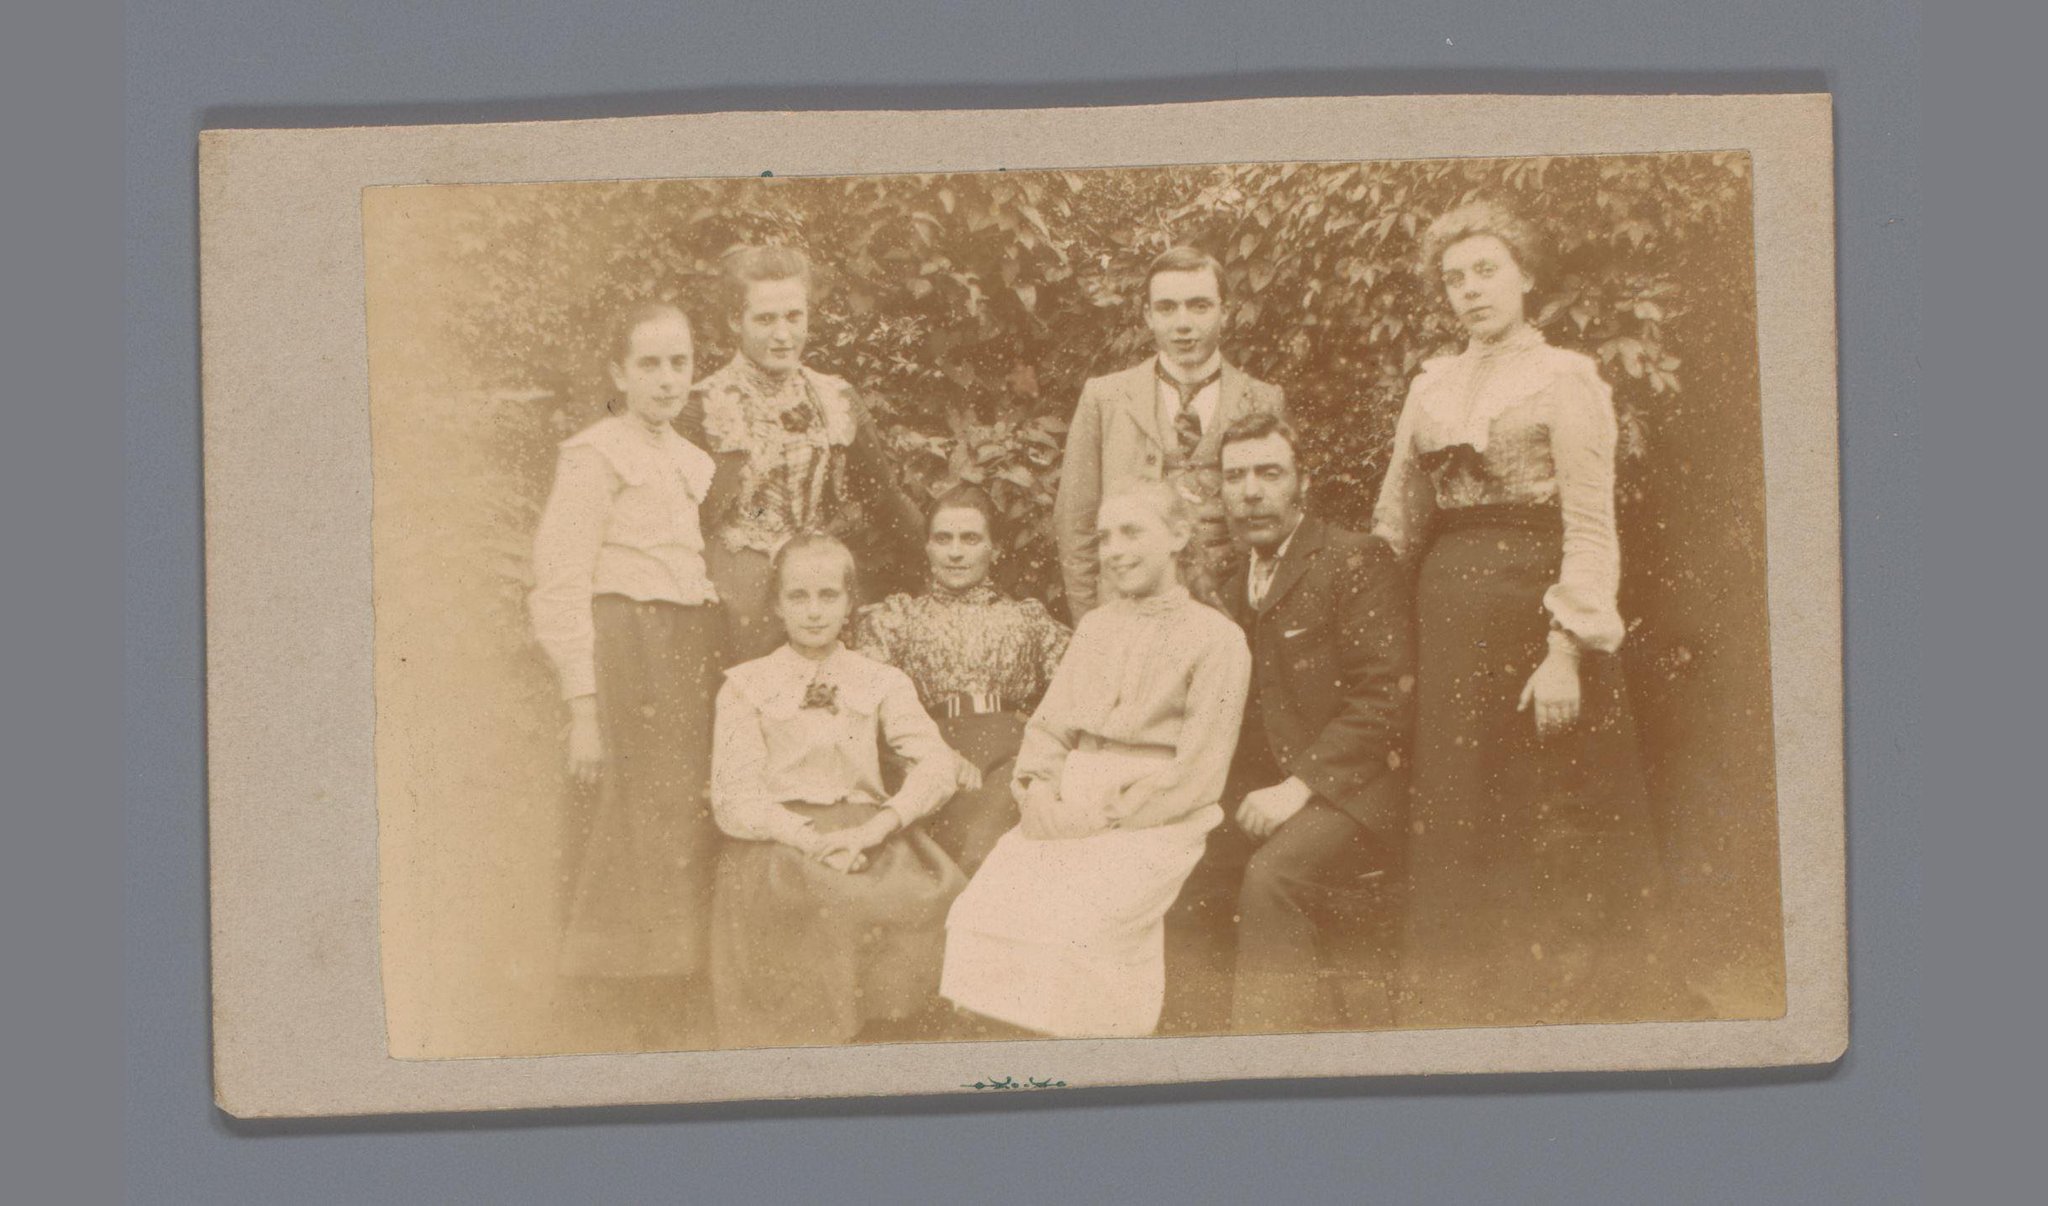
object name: photograph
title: Groepsportret van een familie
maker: Anonymous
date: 1900-1914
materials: paper, cardboard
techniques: gelatin silver print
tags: family, descendance, anonymous historical persons portrayed in a group, in a group-portrait